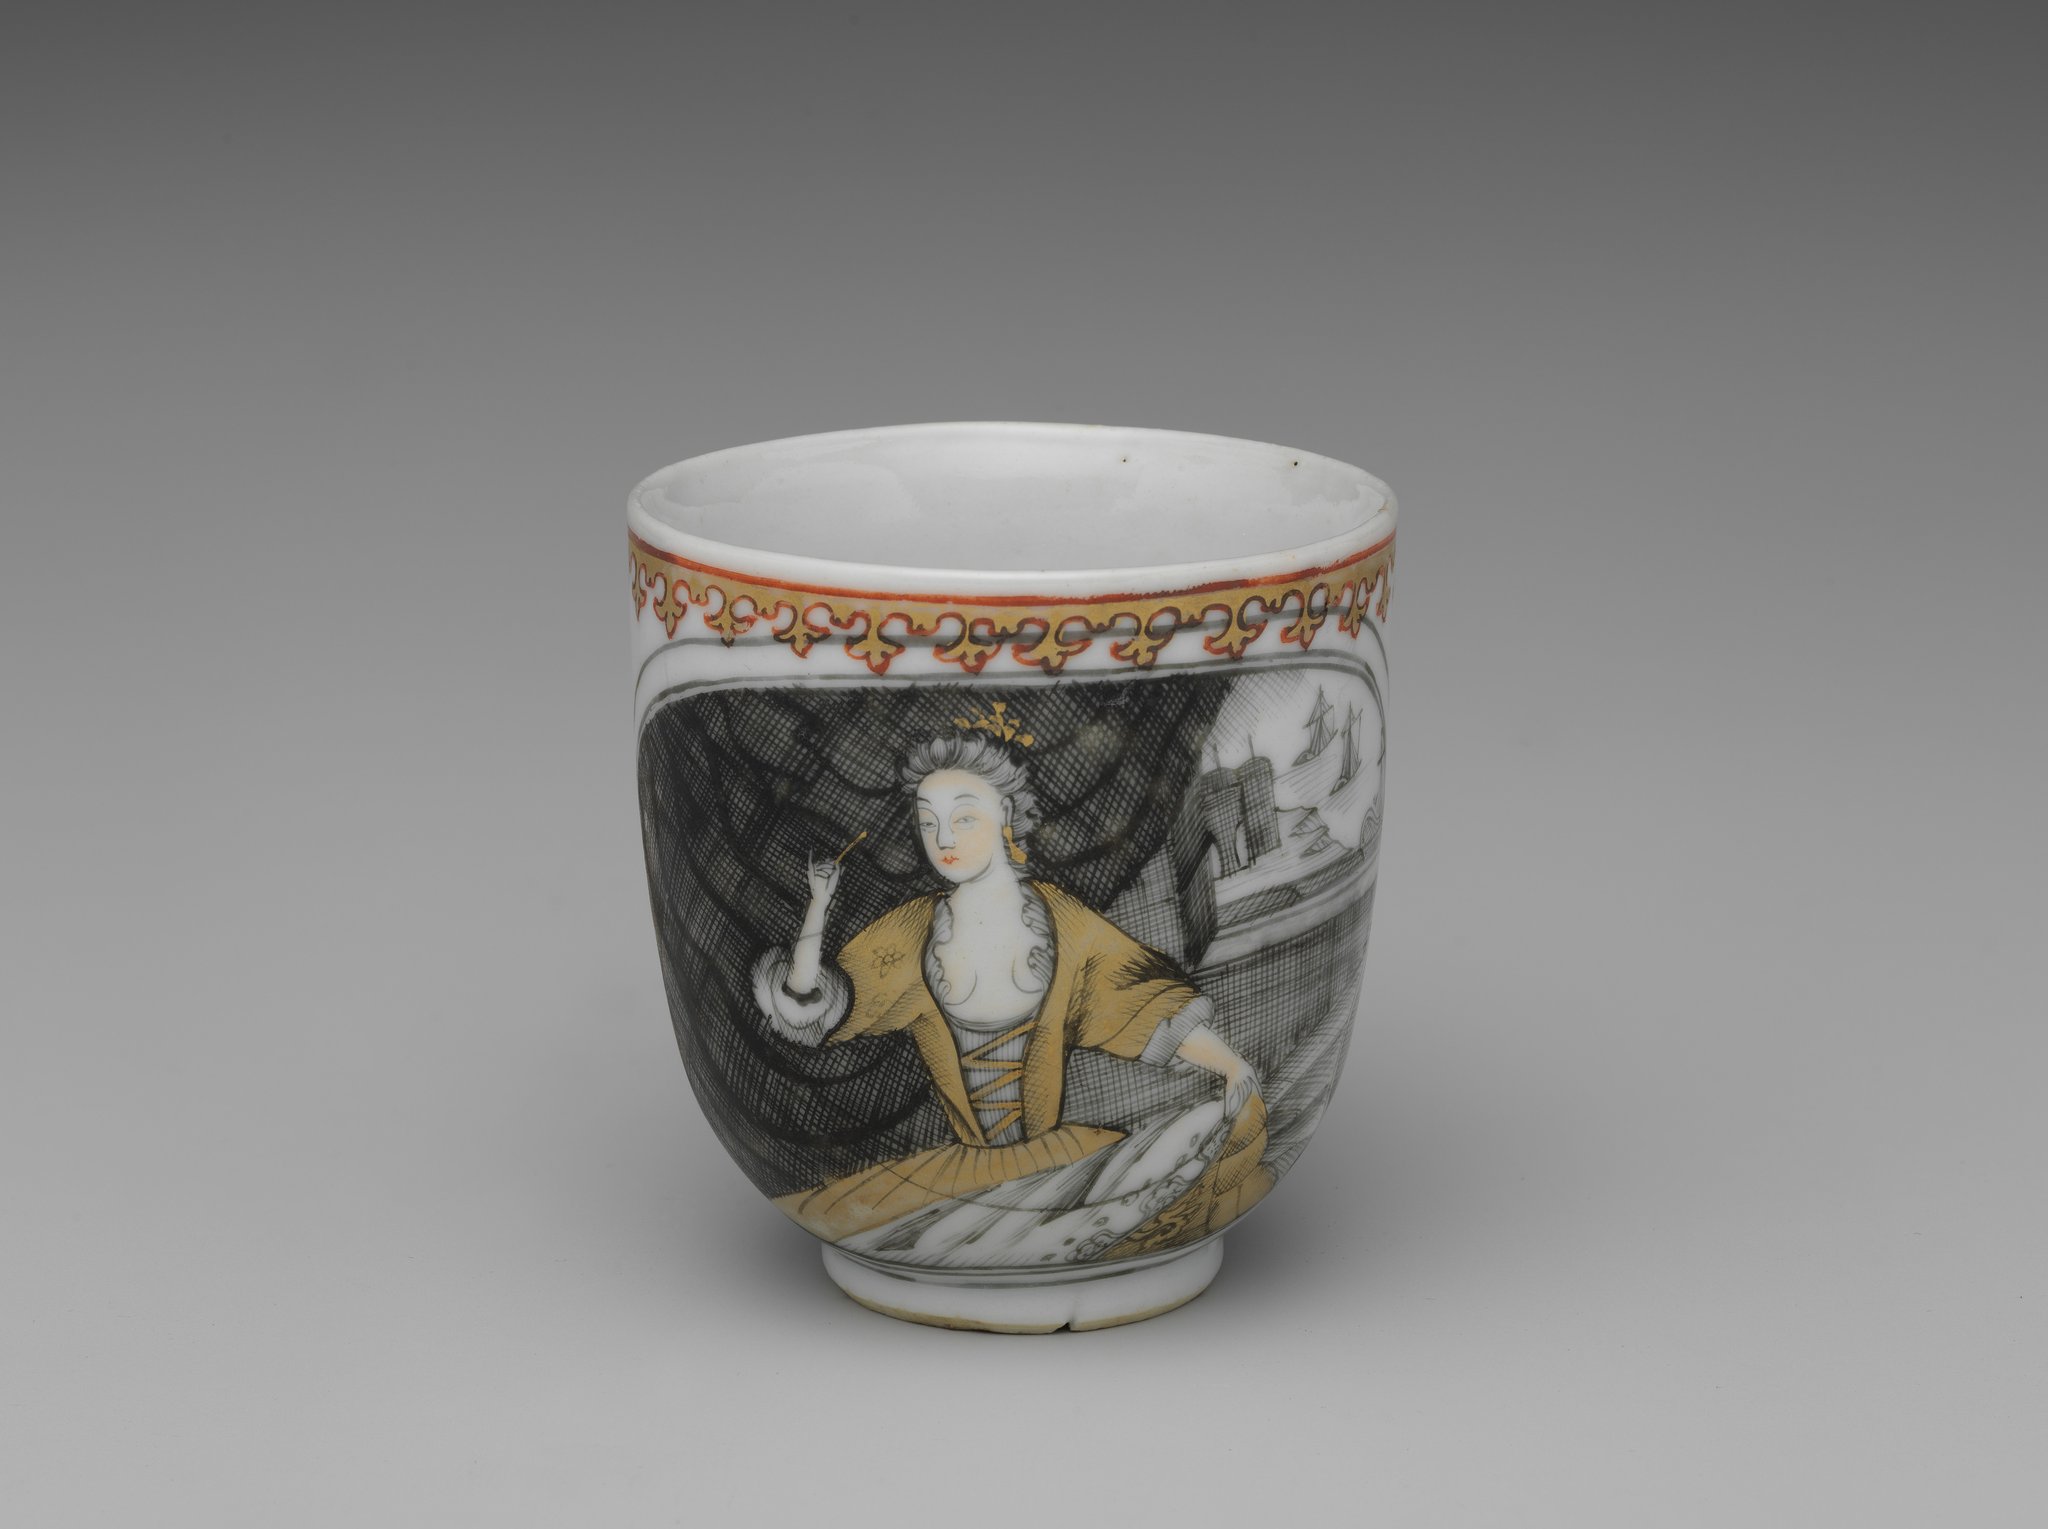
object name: cup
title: Cup (part of a service)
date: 1750-1770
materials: hard paste porcelain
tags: women,needlework,sewing